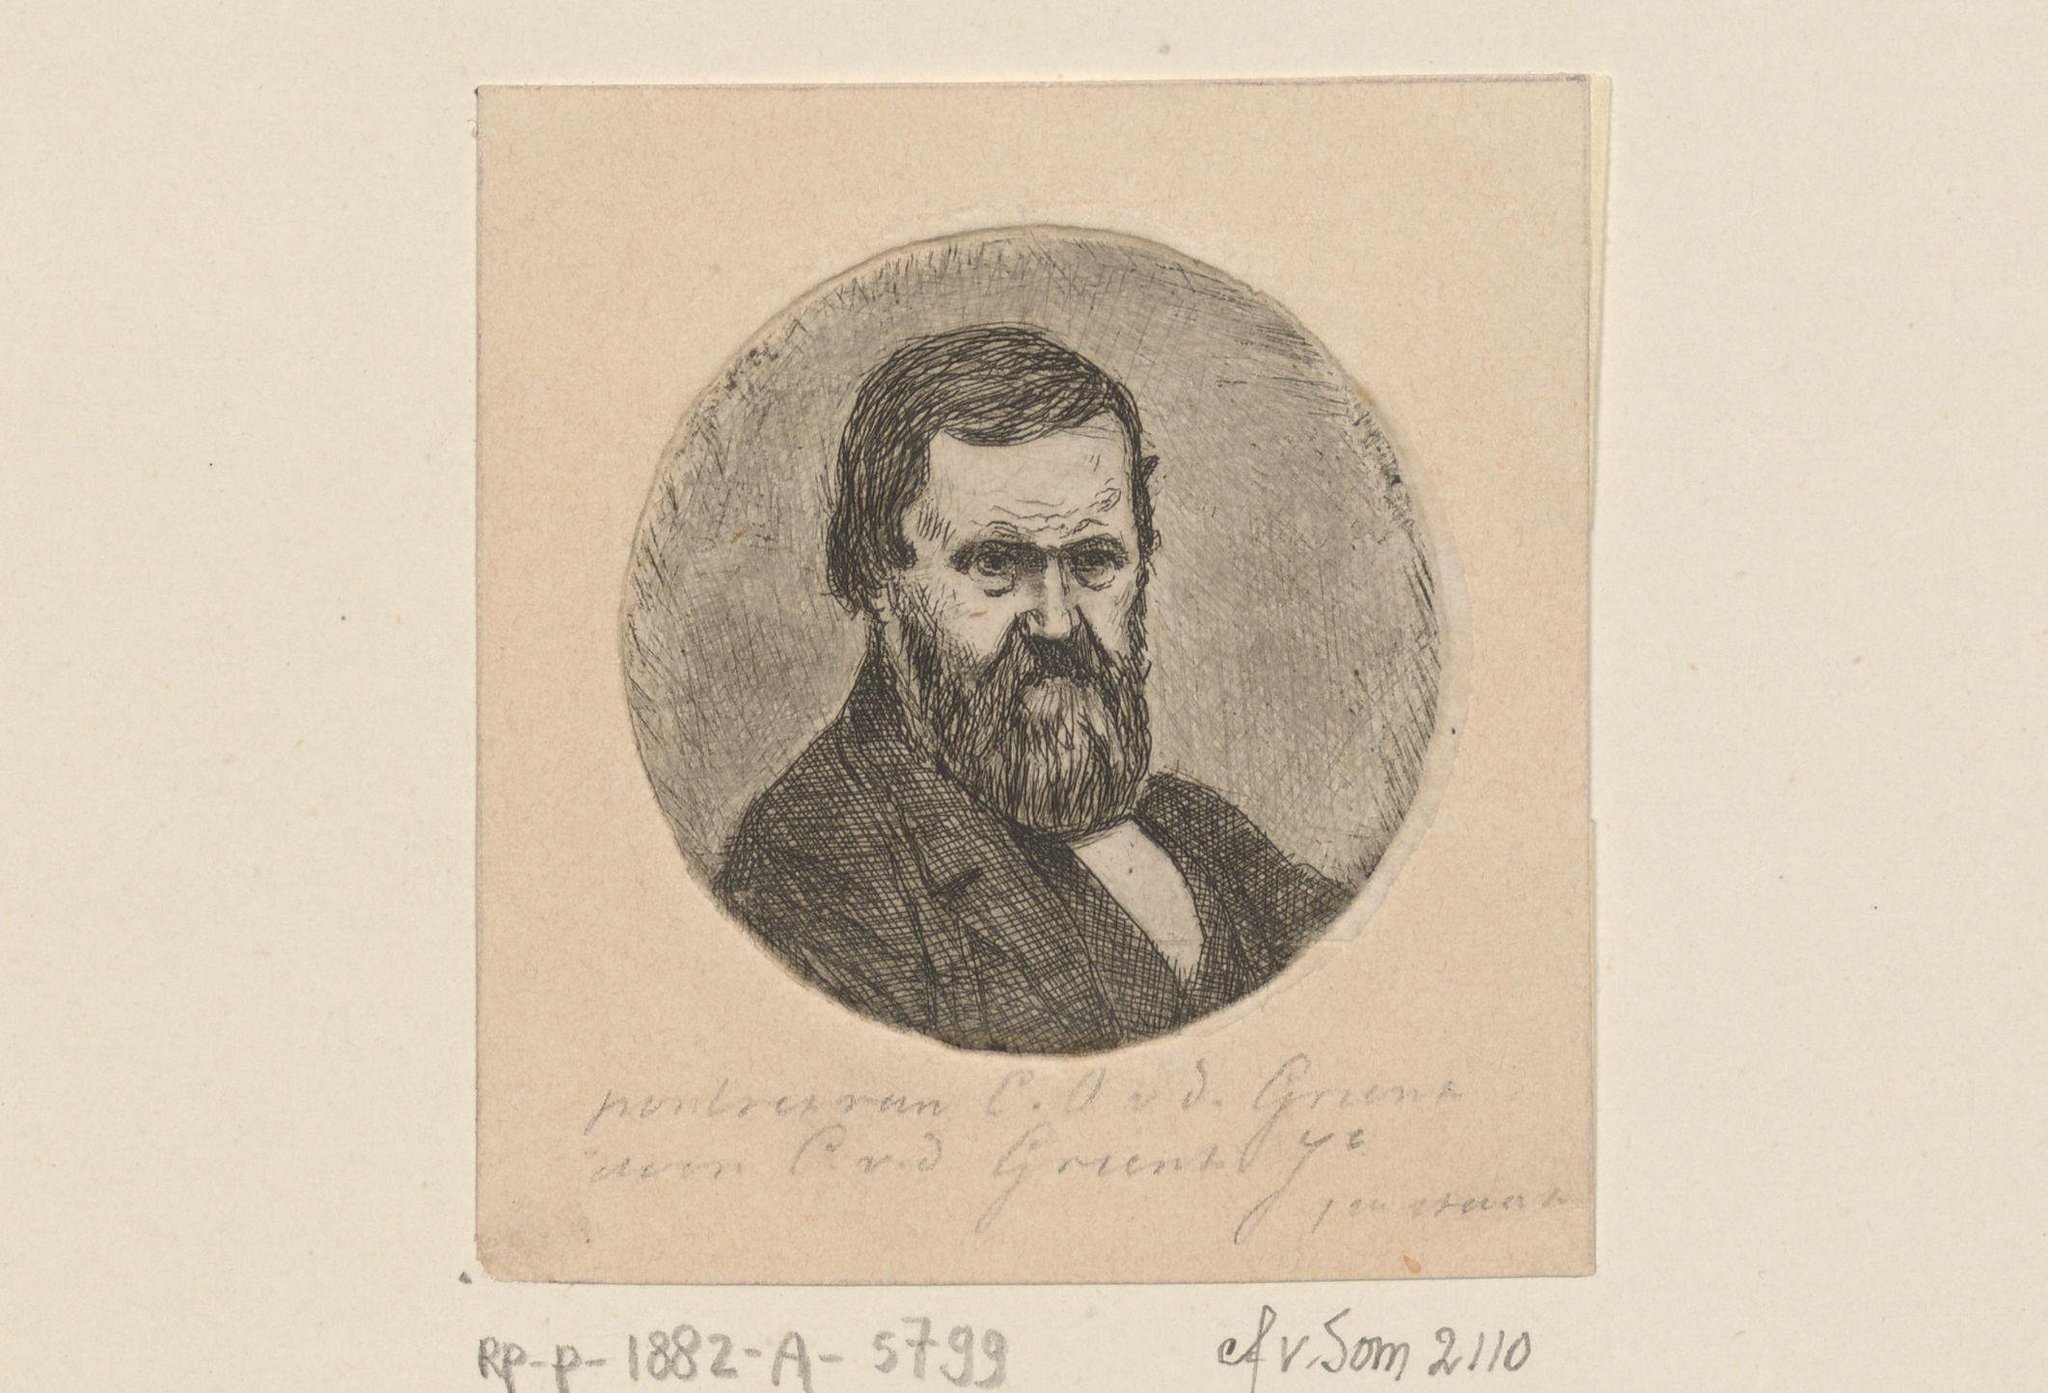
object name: print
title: Zelfportret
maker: cornelis van der griendt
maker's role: draughtsman, painter, print maker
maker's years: 1827-1918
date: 1865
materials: paper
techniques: drypoint, etching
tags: painter, draughtsman, cornelis van der griendt, historical persons, portrait, self-portrait of graphic artist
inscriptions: collector's mark: Lugt 2227